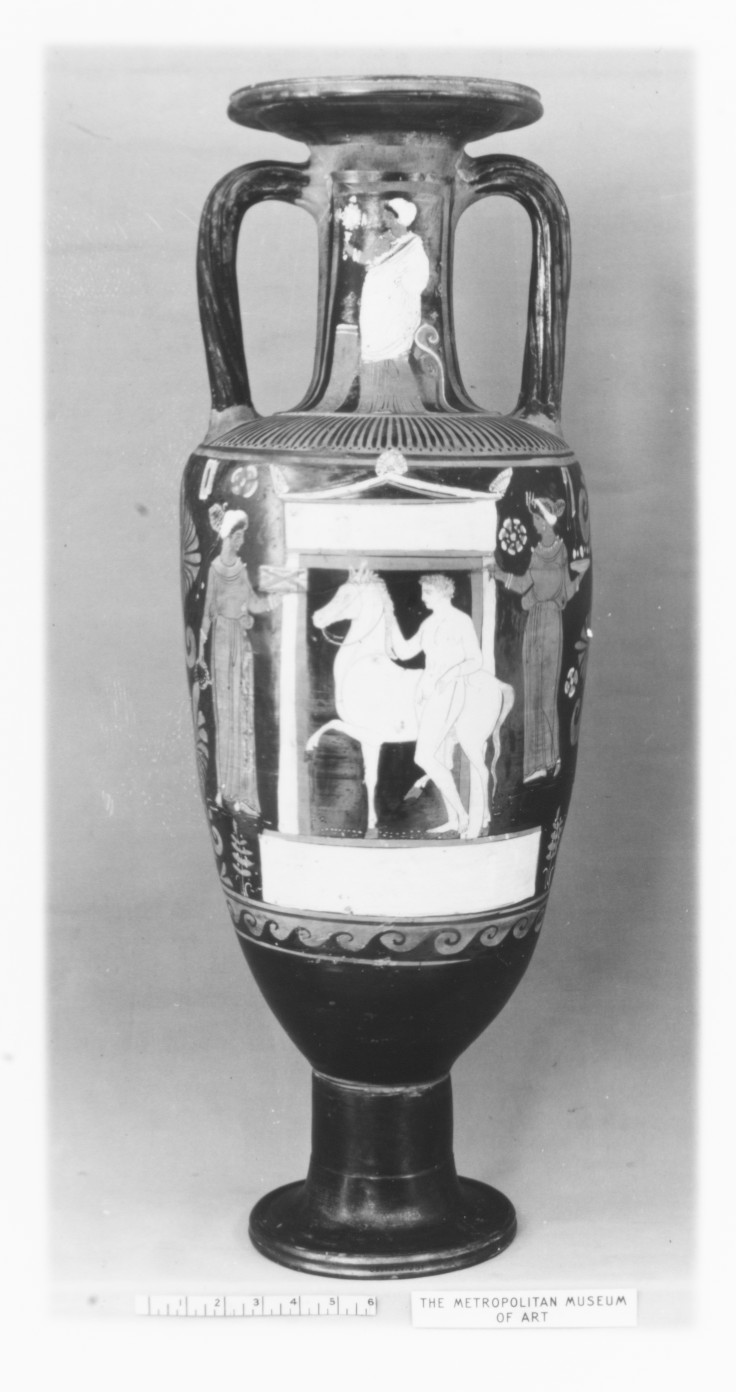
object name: neck amphora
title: Terracotta neck-amphora (jar)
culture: greek or south italian or campanian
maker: apz painter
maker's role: artist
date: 330-300 BCE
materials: terracotta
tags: men,women,horses